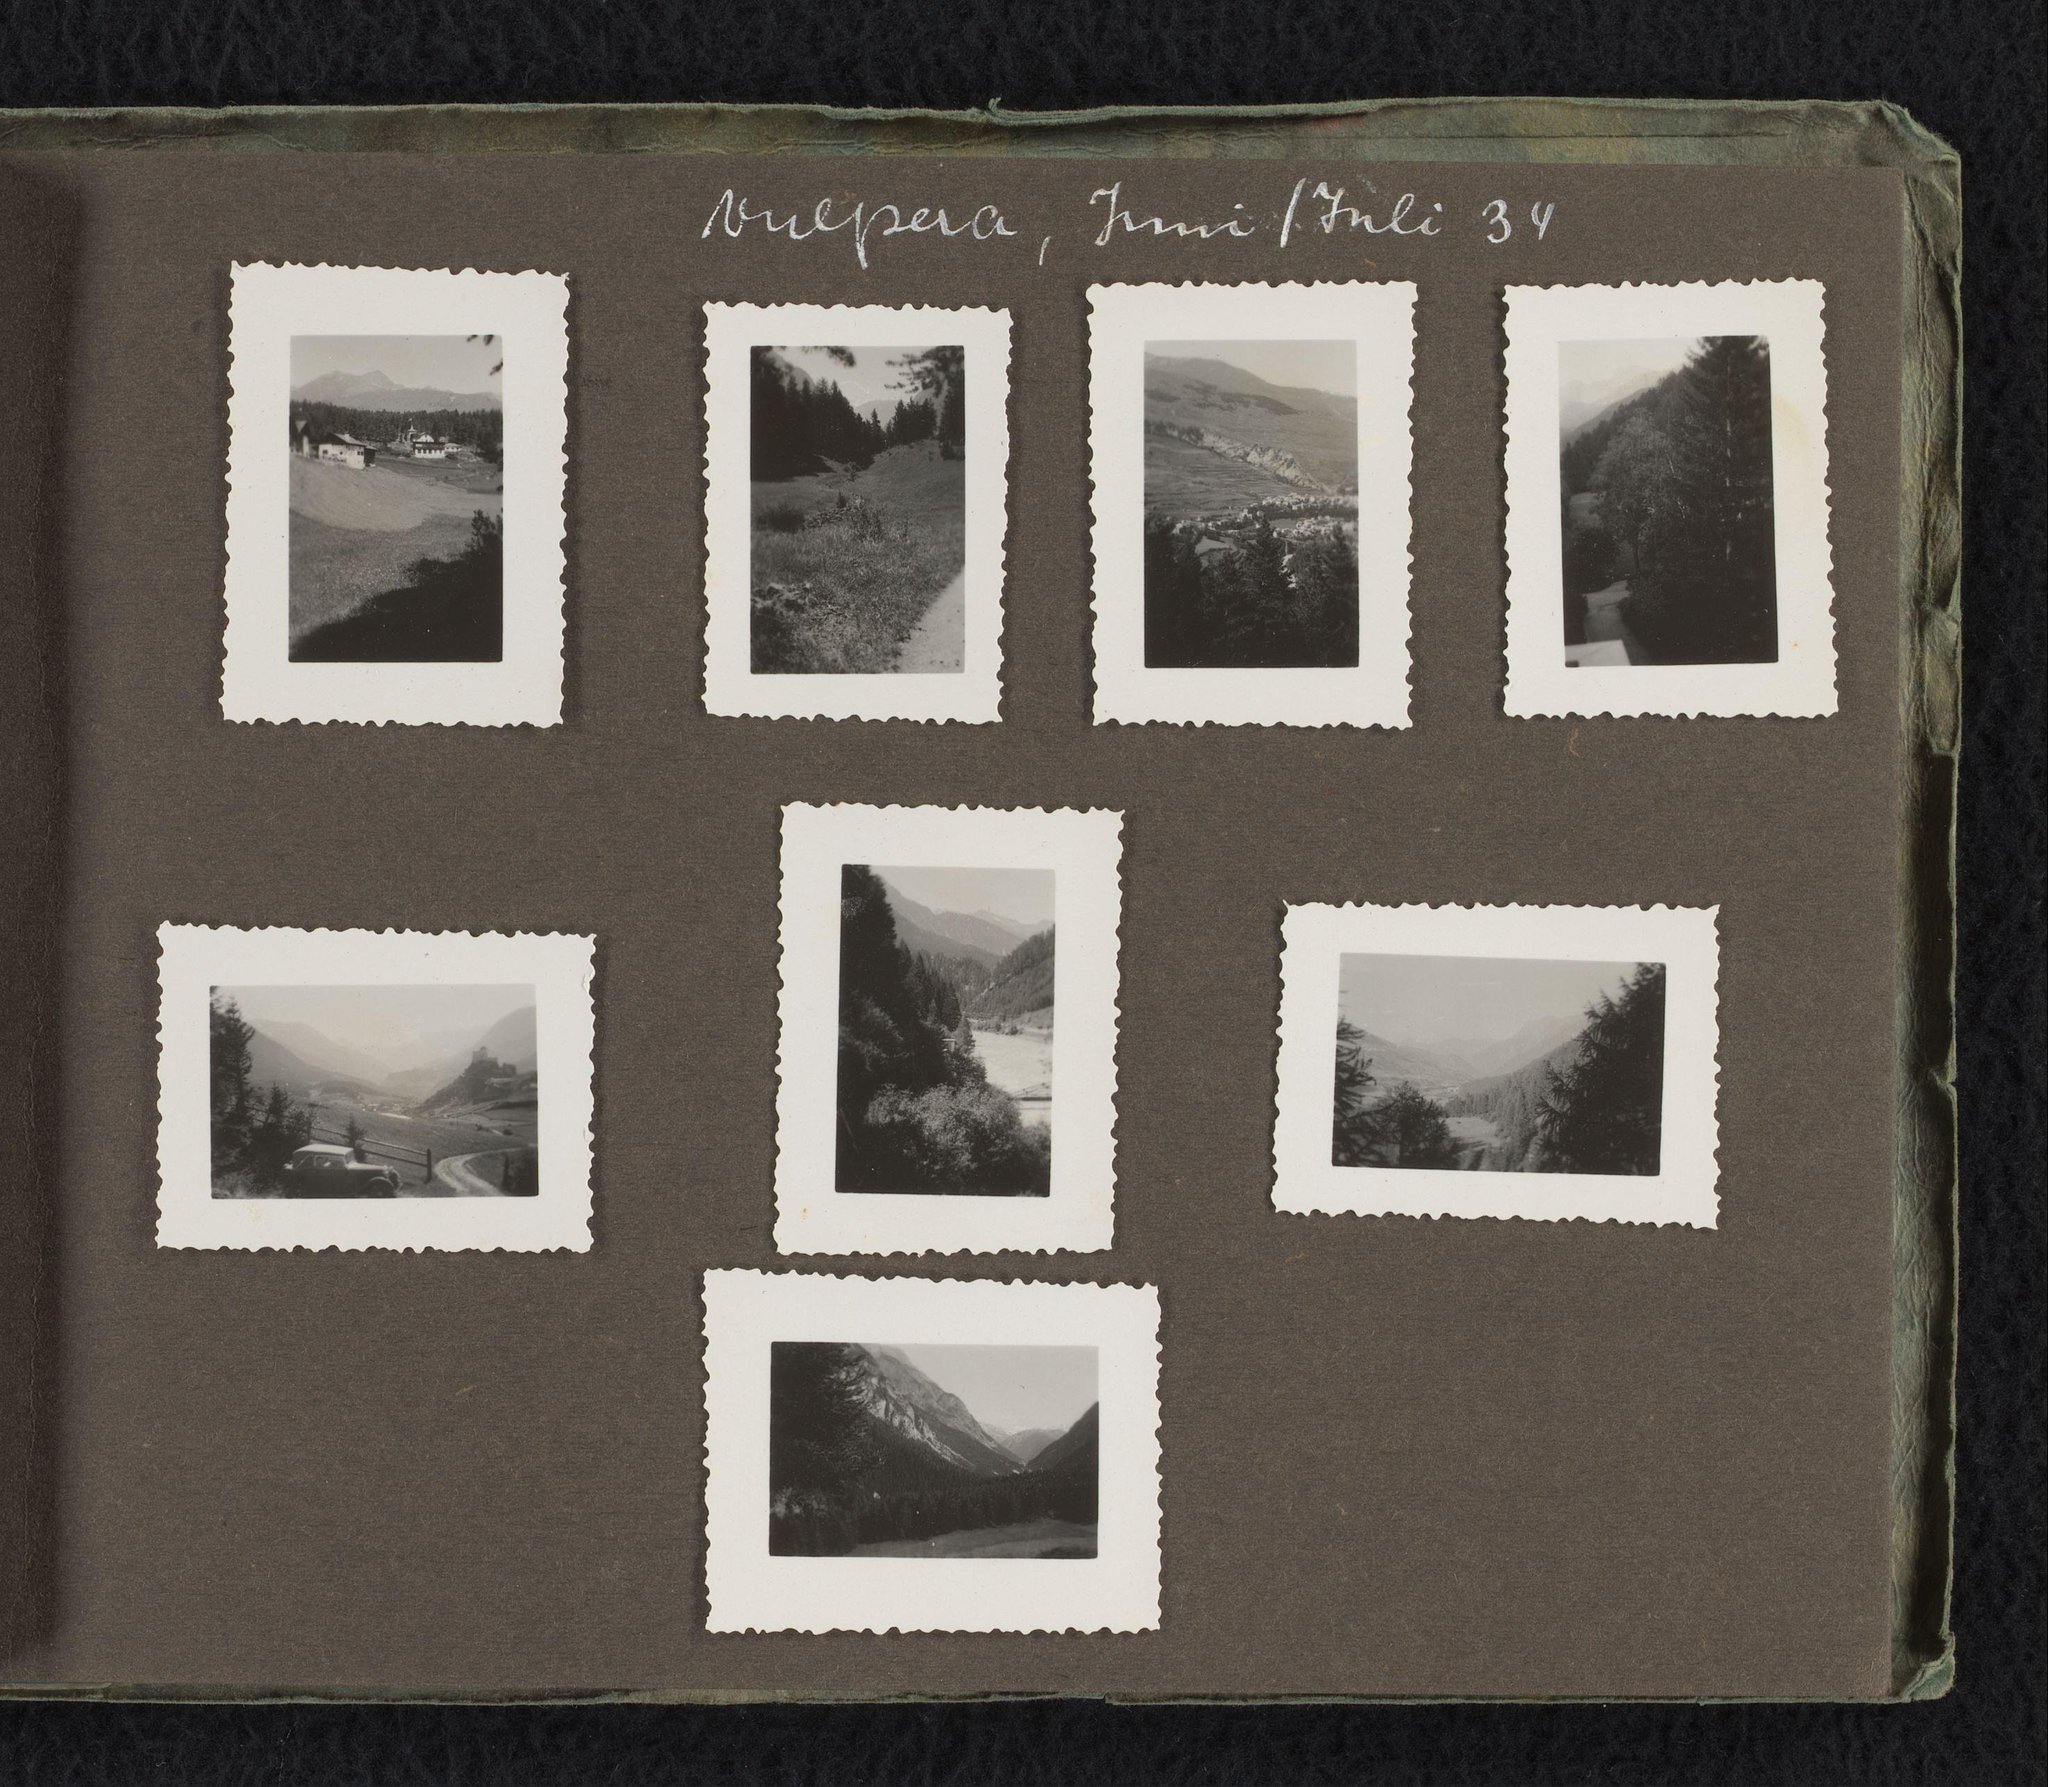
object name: photograph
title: Natuurgezichten tijdens een vakantie van de familie Wachenheimer, juni-juli 1934, Vulpera (Zwitserland)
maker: else wachenheimer-moos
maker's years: 1895-1944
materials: paper, photographic support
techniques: gelatin silver print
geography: switzerland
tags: the family travelling, on holiday, mountains, switzerland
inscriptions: inscription: ‘Vulpera, Juni/Juli 34’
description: Blad bevat zeven foto's met natuurgezichten. Uit het album, half formaat, groen geaderd kartonomslag met koordbinding.